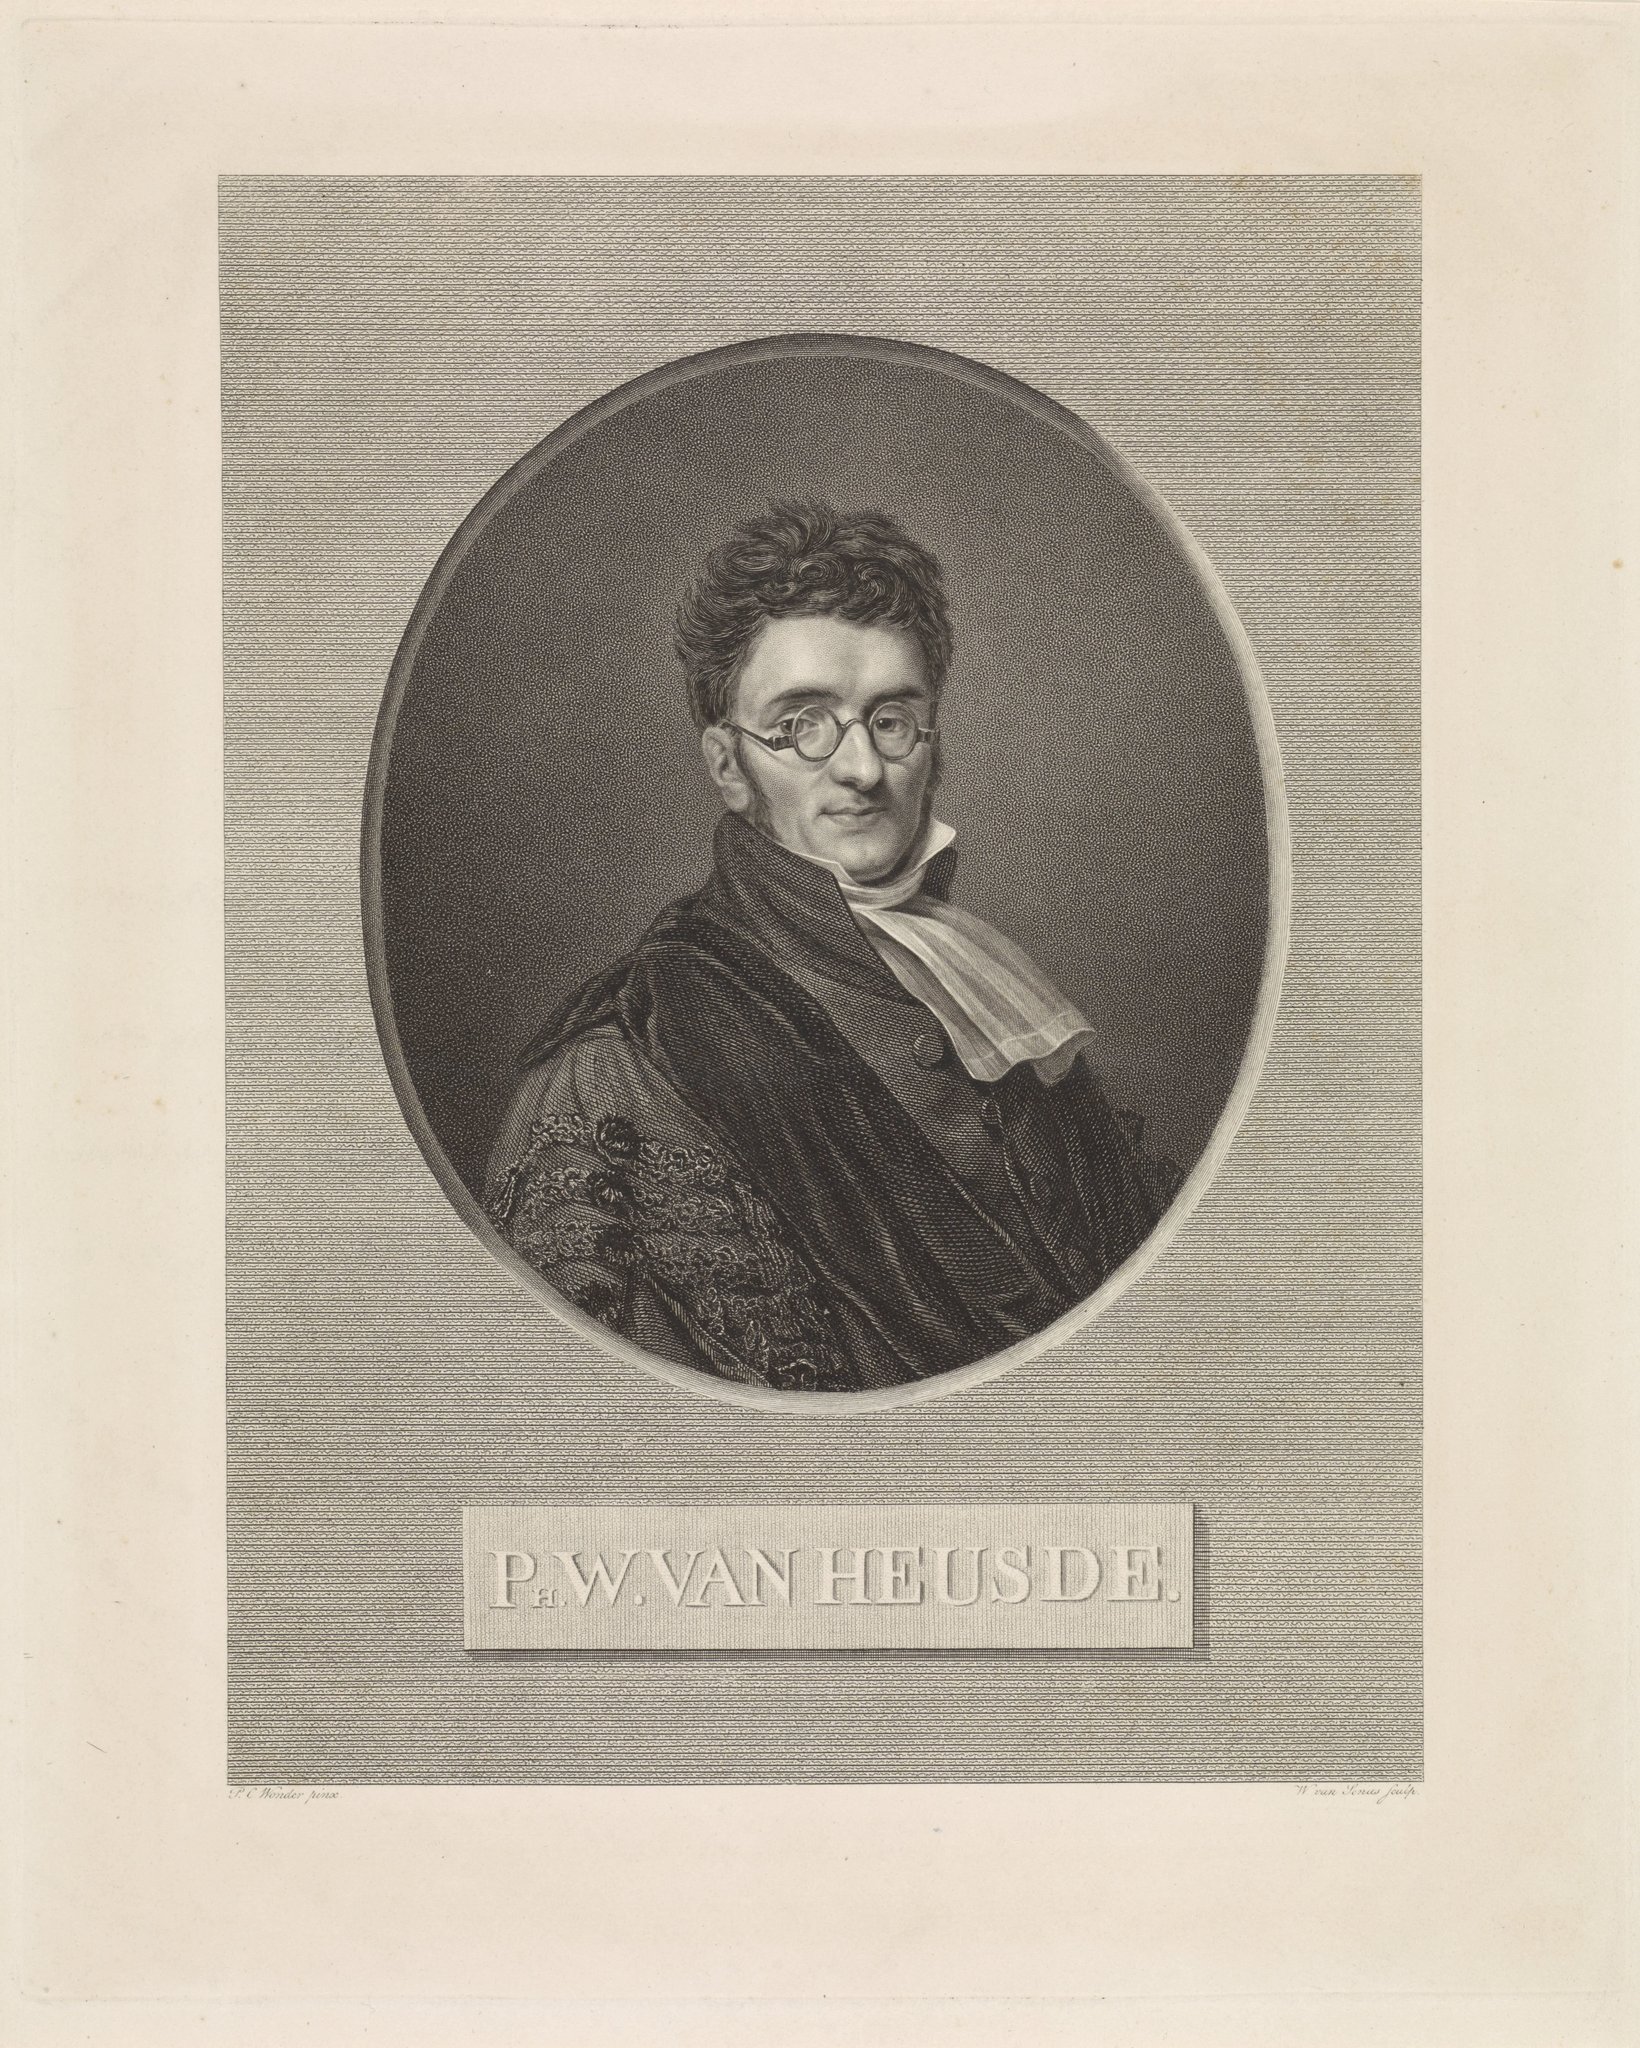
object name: print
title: Portret van Philip Willem van Heusde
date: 1803-1851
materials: paper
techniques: engraving, etching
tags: rotterdam, eyeglasses, spectacles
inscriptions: collector's mark: Lugt 2228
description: Portret van Philip Willem van Heusde, hoogleraar filosofie en letteren in Utrecht.